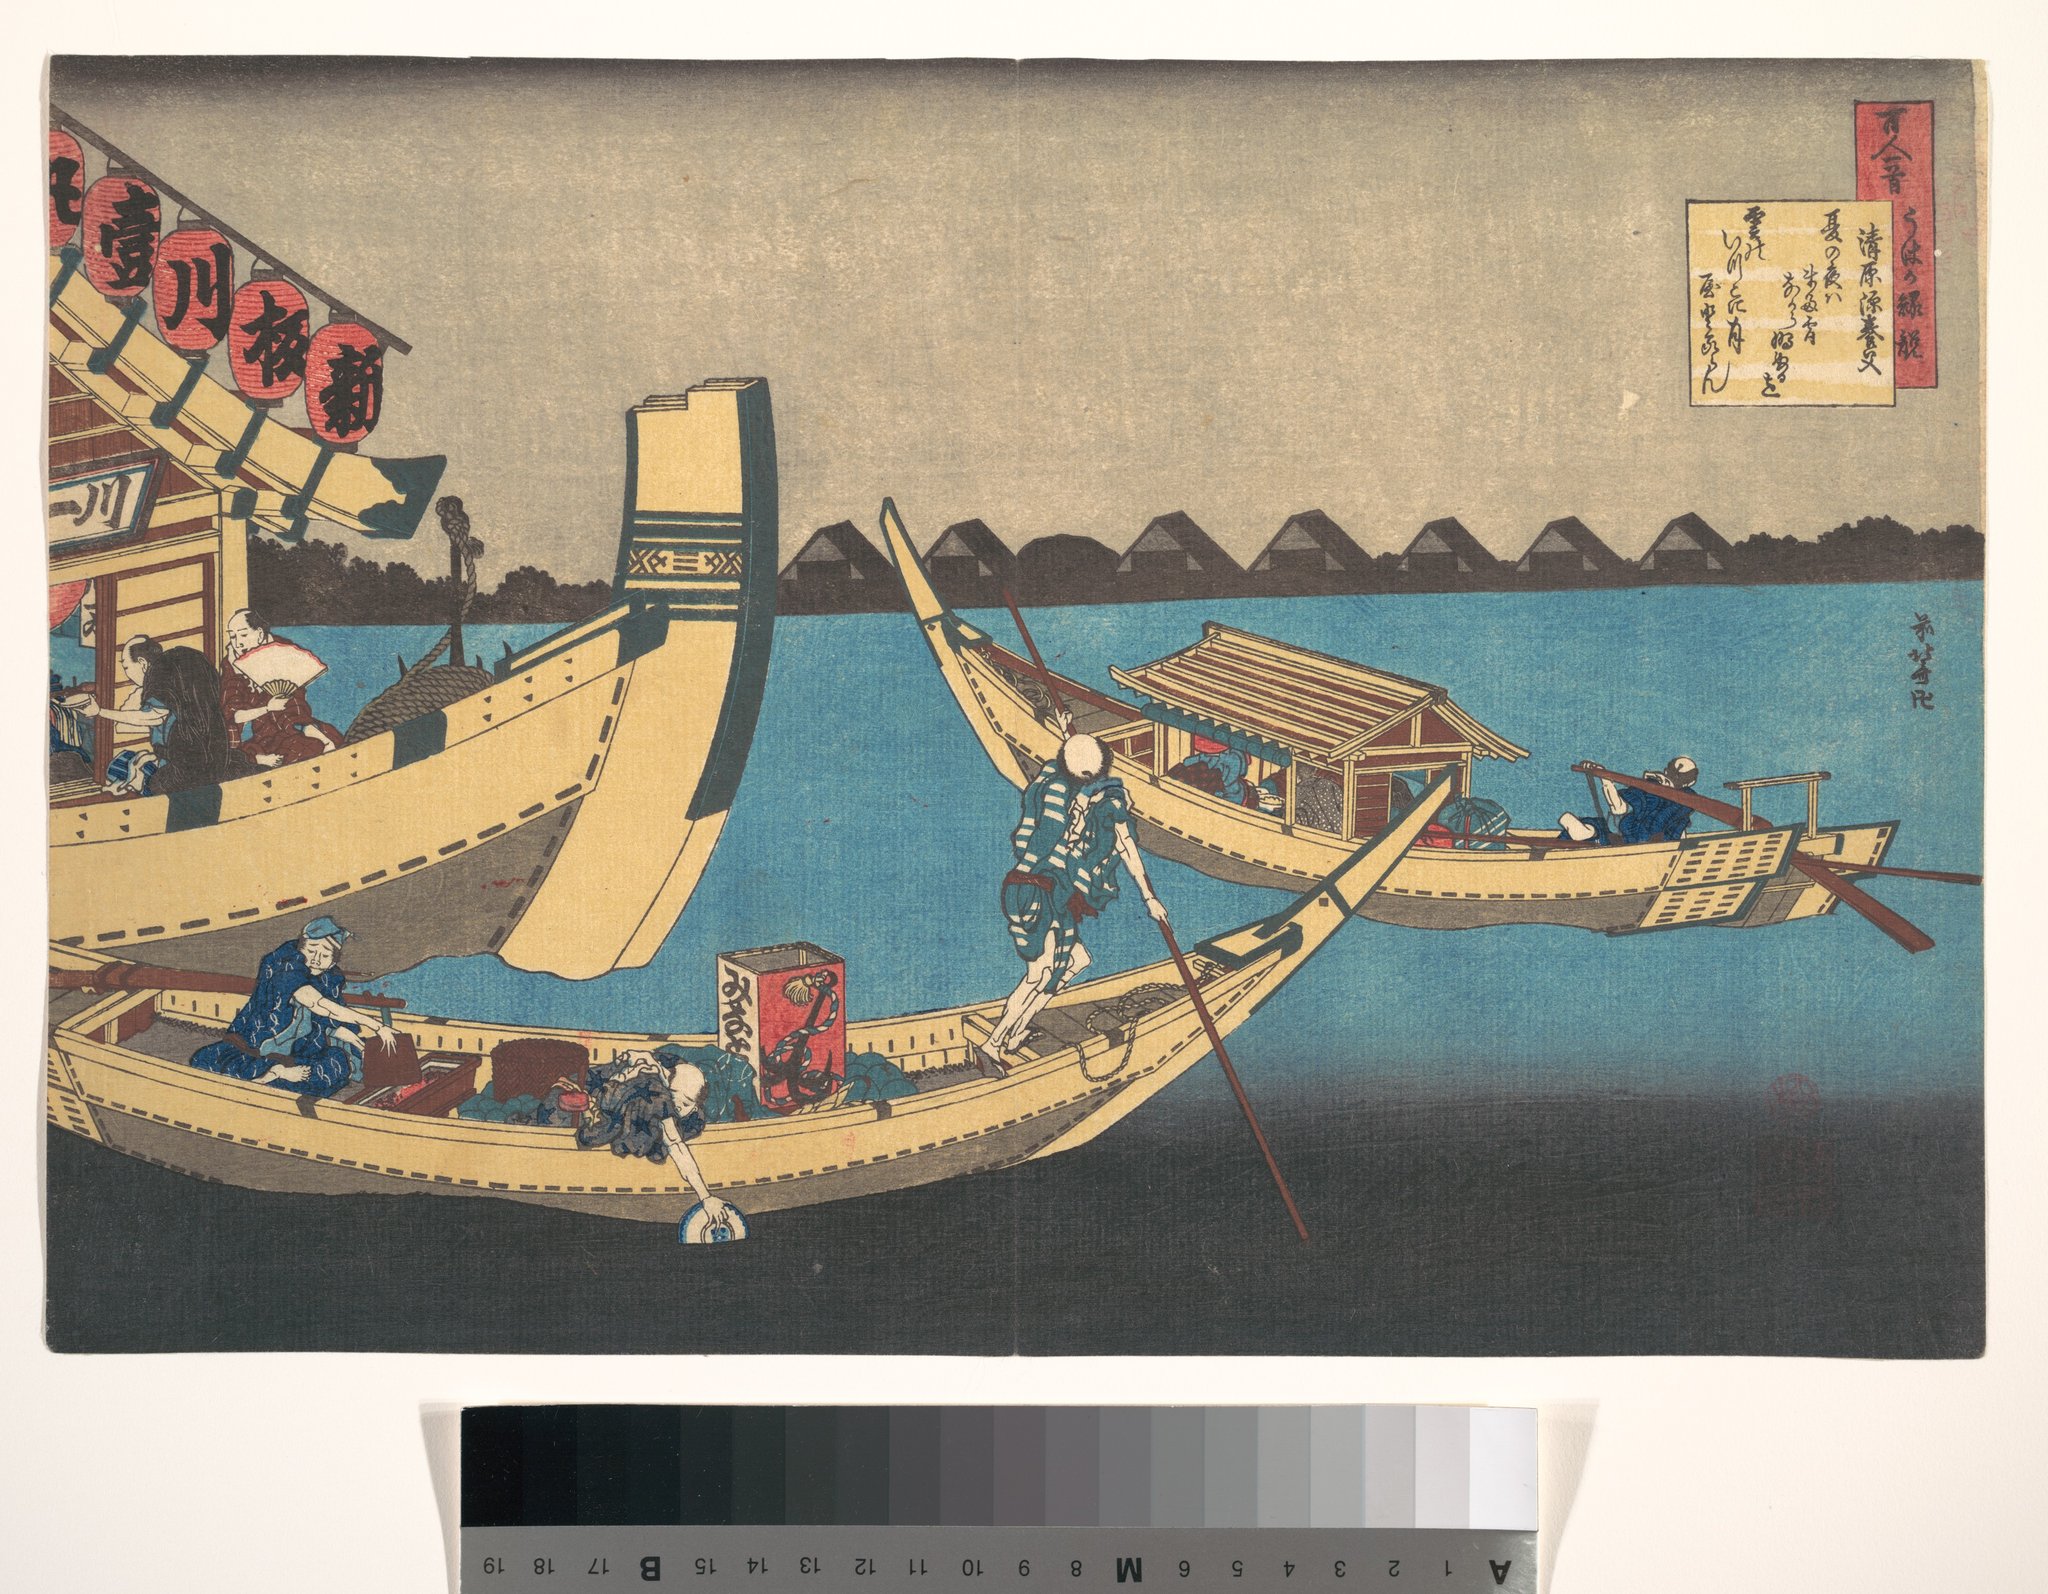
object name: woodblock print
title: Poem by Kiyohara no Fukayabu, from the series One Hundred Poems Explained by the Nurse (Hyakunin isshu uba ga etoki)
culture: japanese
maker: katsushika hokusai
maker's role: artist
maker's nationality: japanese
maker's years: 1760-1849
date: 1835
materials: ink, paper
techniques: woodblock print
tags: men,rivers,boats,lanterns